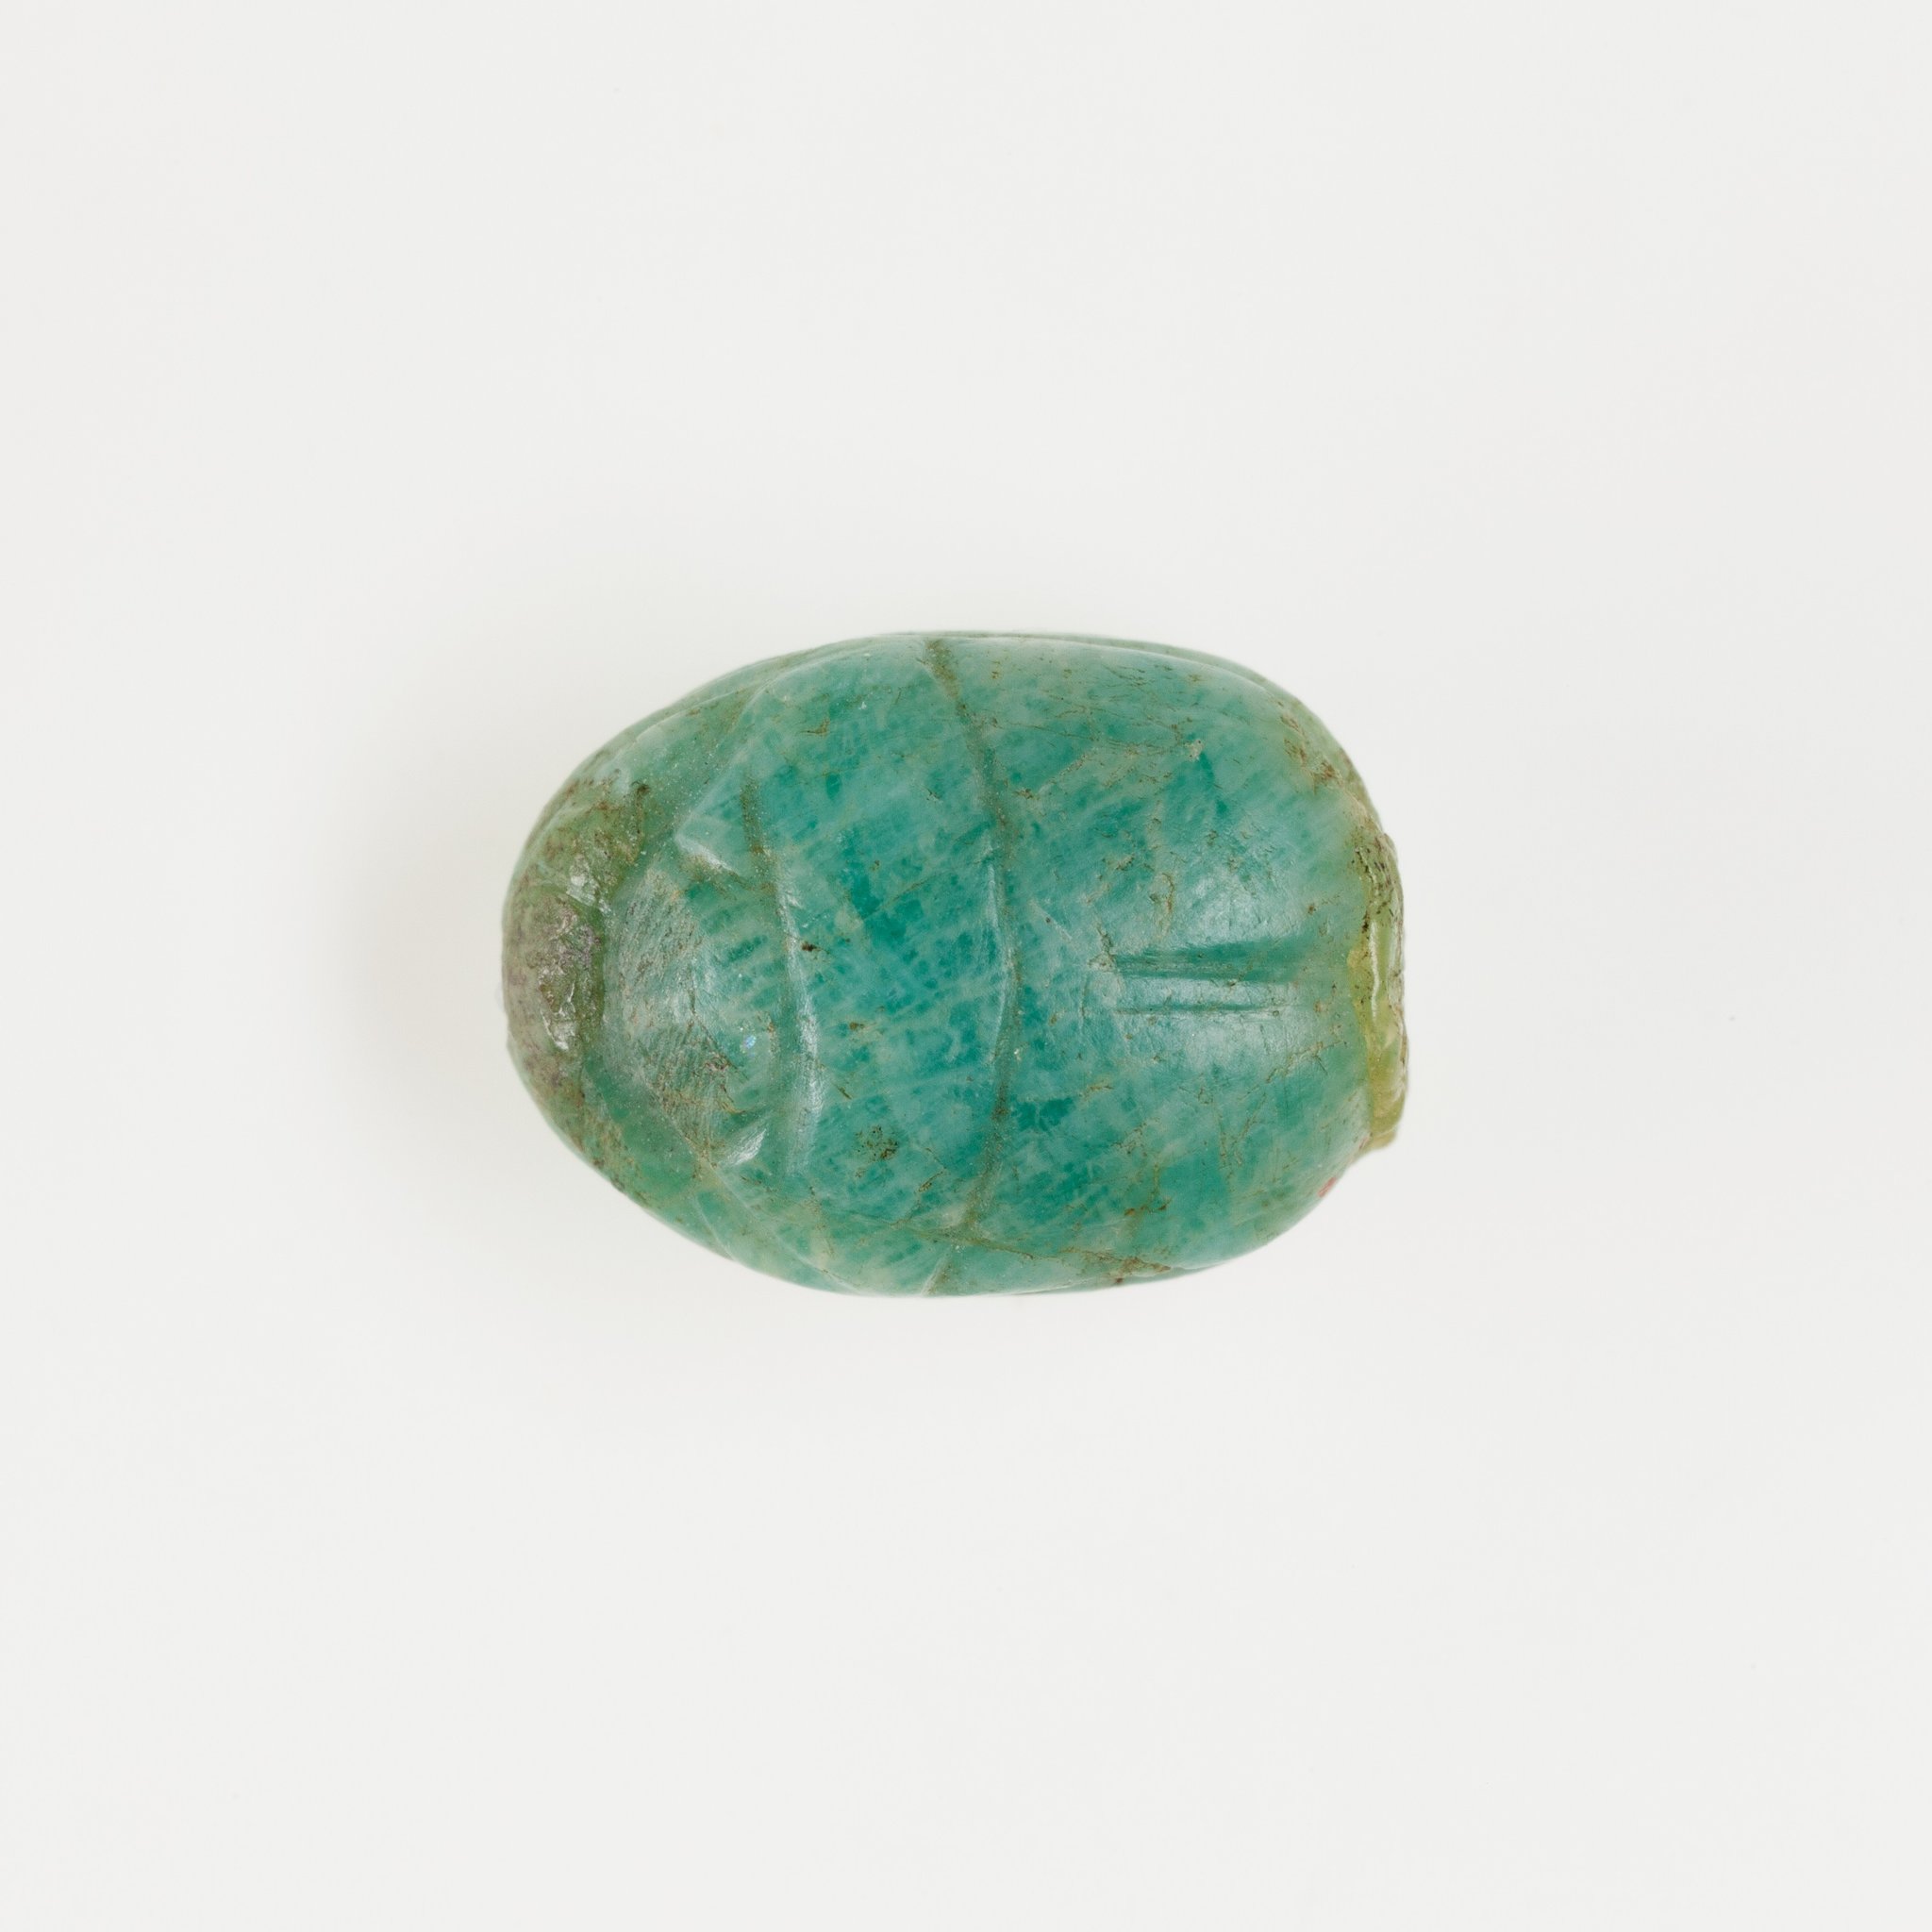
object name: scarab, uninscribed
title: Scarab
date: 1981-1550 BCE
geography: egypt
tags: scarabs